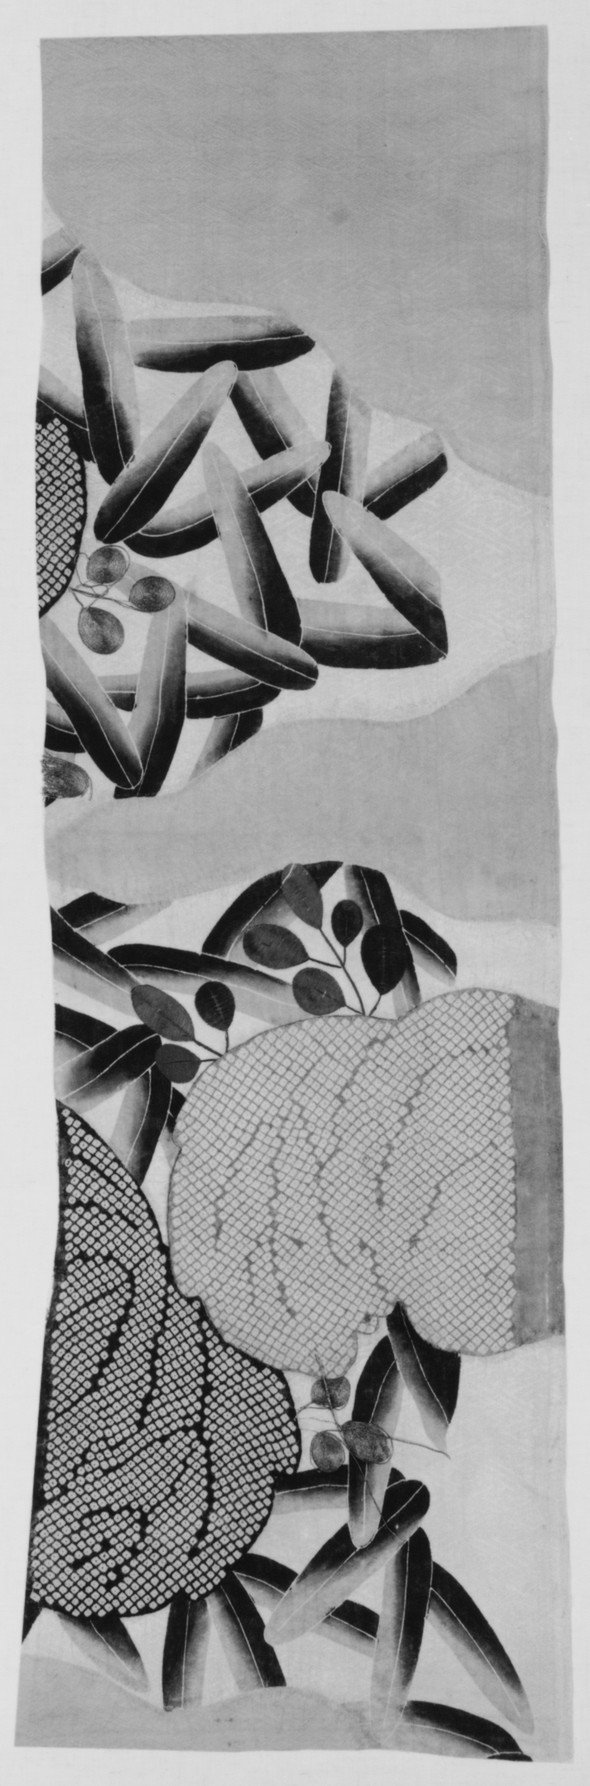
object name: piece from a kosode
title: Kosode Fragment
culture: japanese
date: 1667-1733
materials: dye, textile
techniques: damask